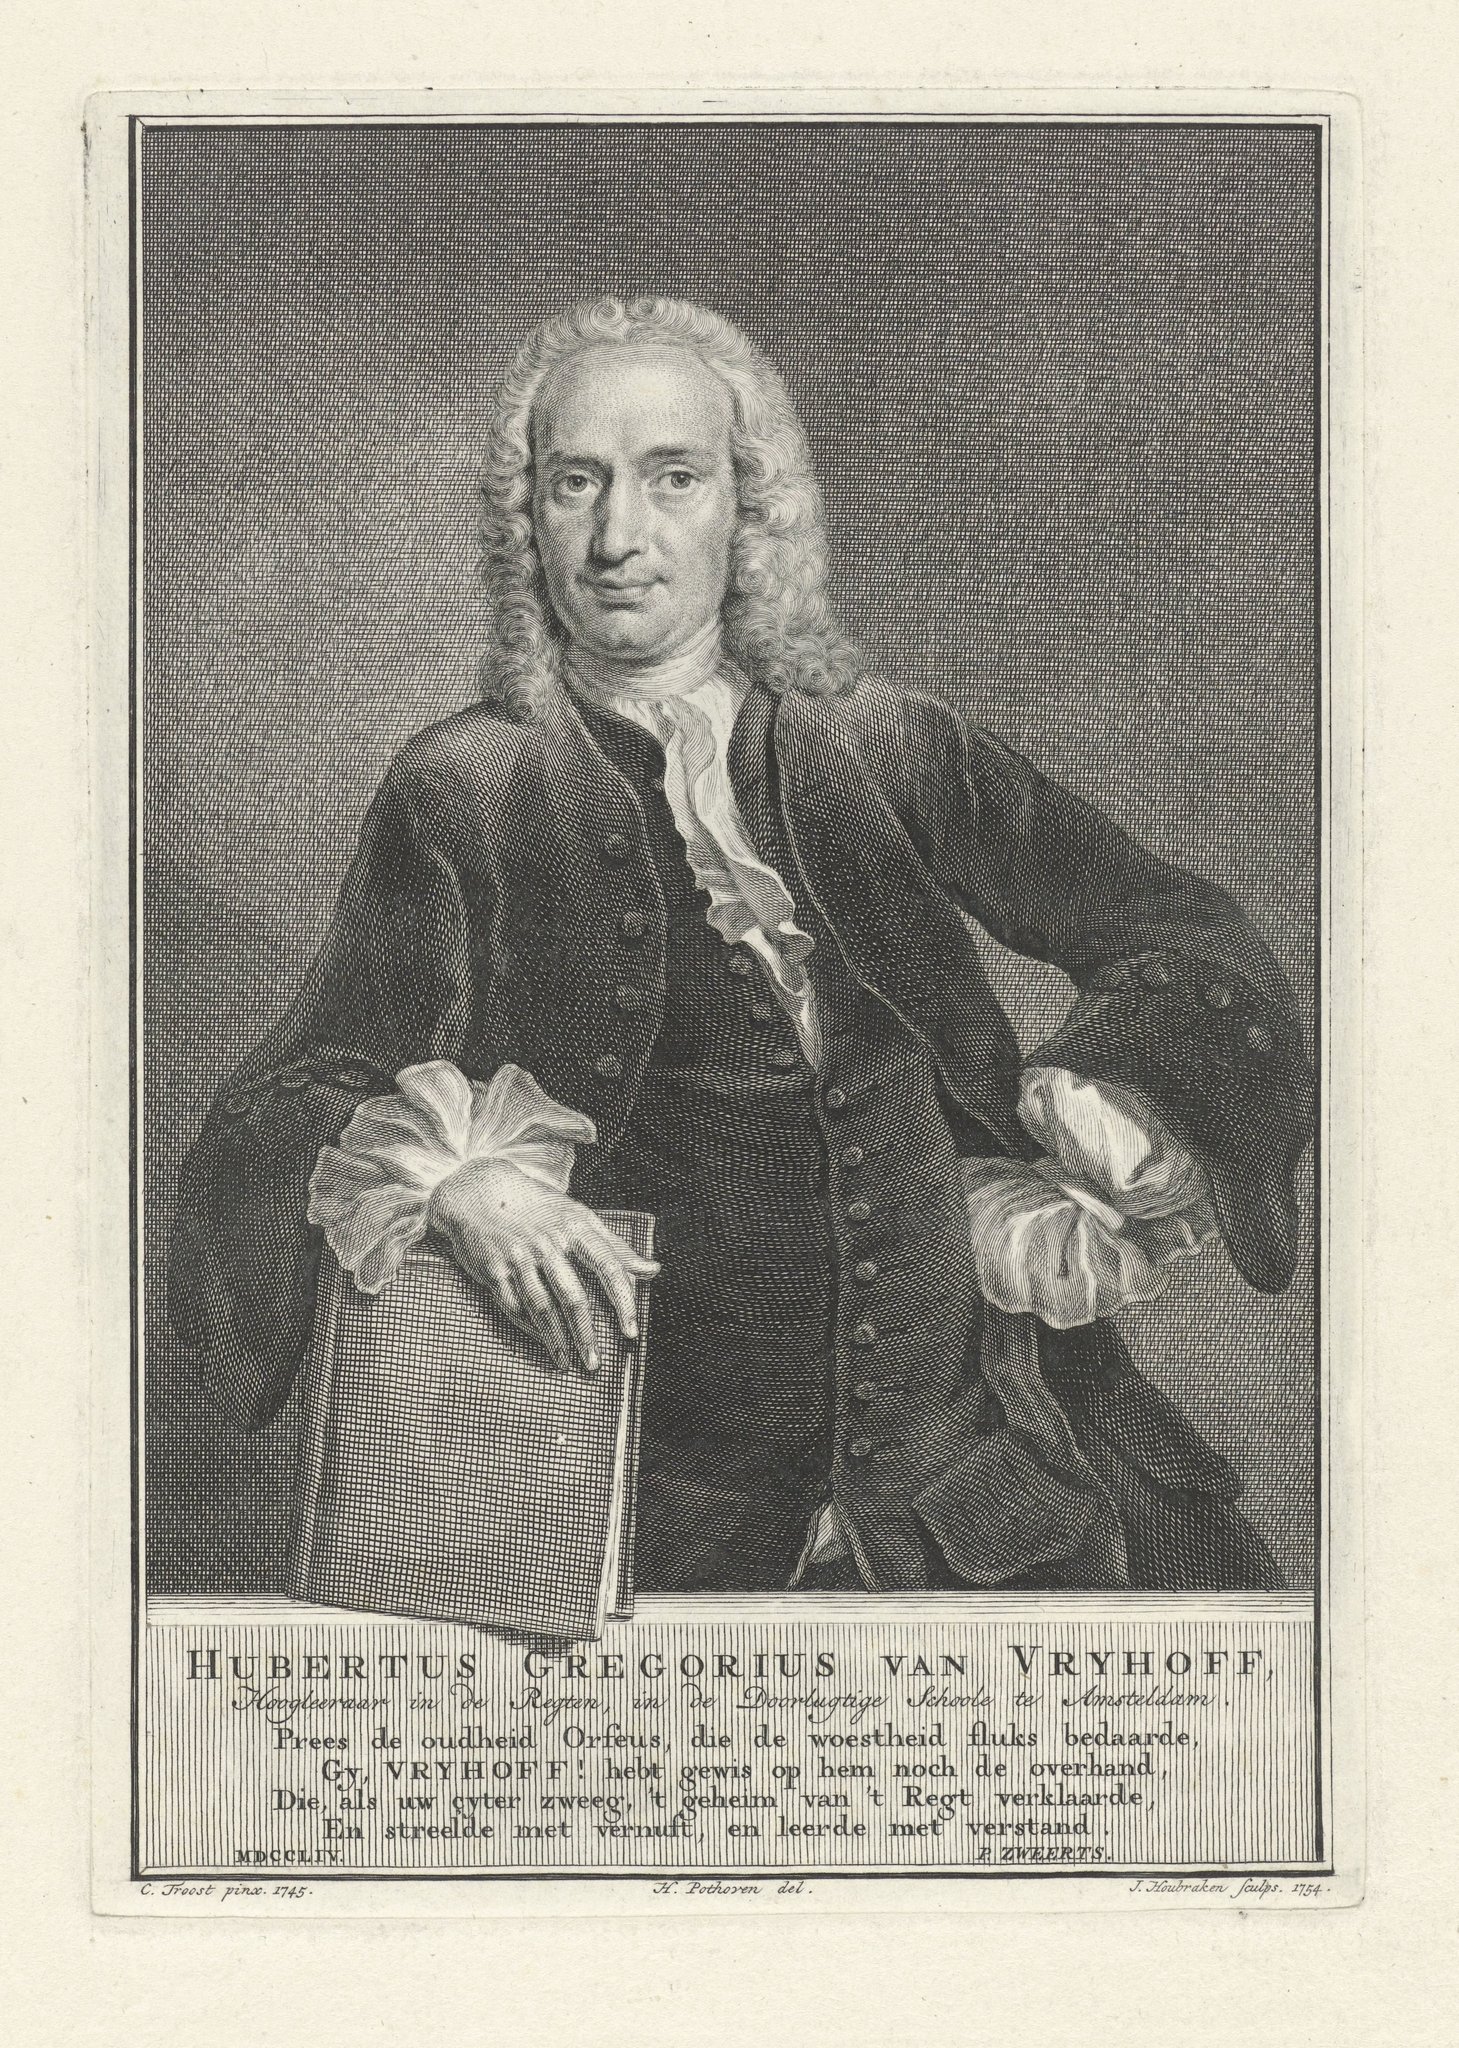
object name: print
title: Portret van Hubertus Gregorius van Vrijhoff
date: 1754-1755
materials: paper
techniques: engraving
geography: amsterdam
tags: historical persons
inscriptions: collector's mark: Lugt 240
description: Portret van hoogleraar Rechten aan het Athenaeum Illustre (de voorloper van de Universiteit van Amsterdam) Hubertus Gregorius van Vrijhoff, zijn arm rustende op een boek op een plint voor hem. Op de plint zijn naam en beroep en een vierregelig vers, in het Nederlands.